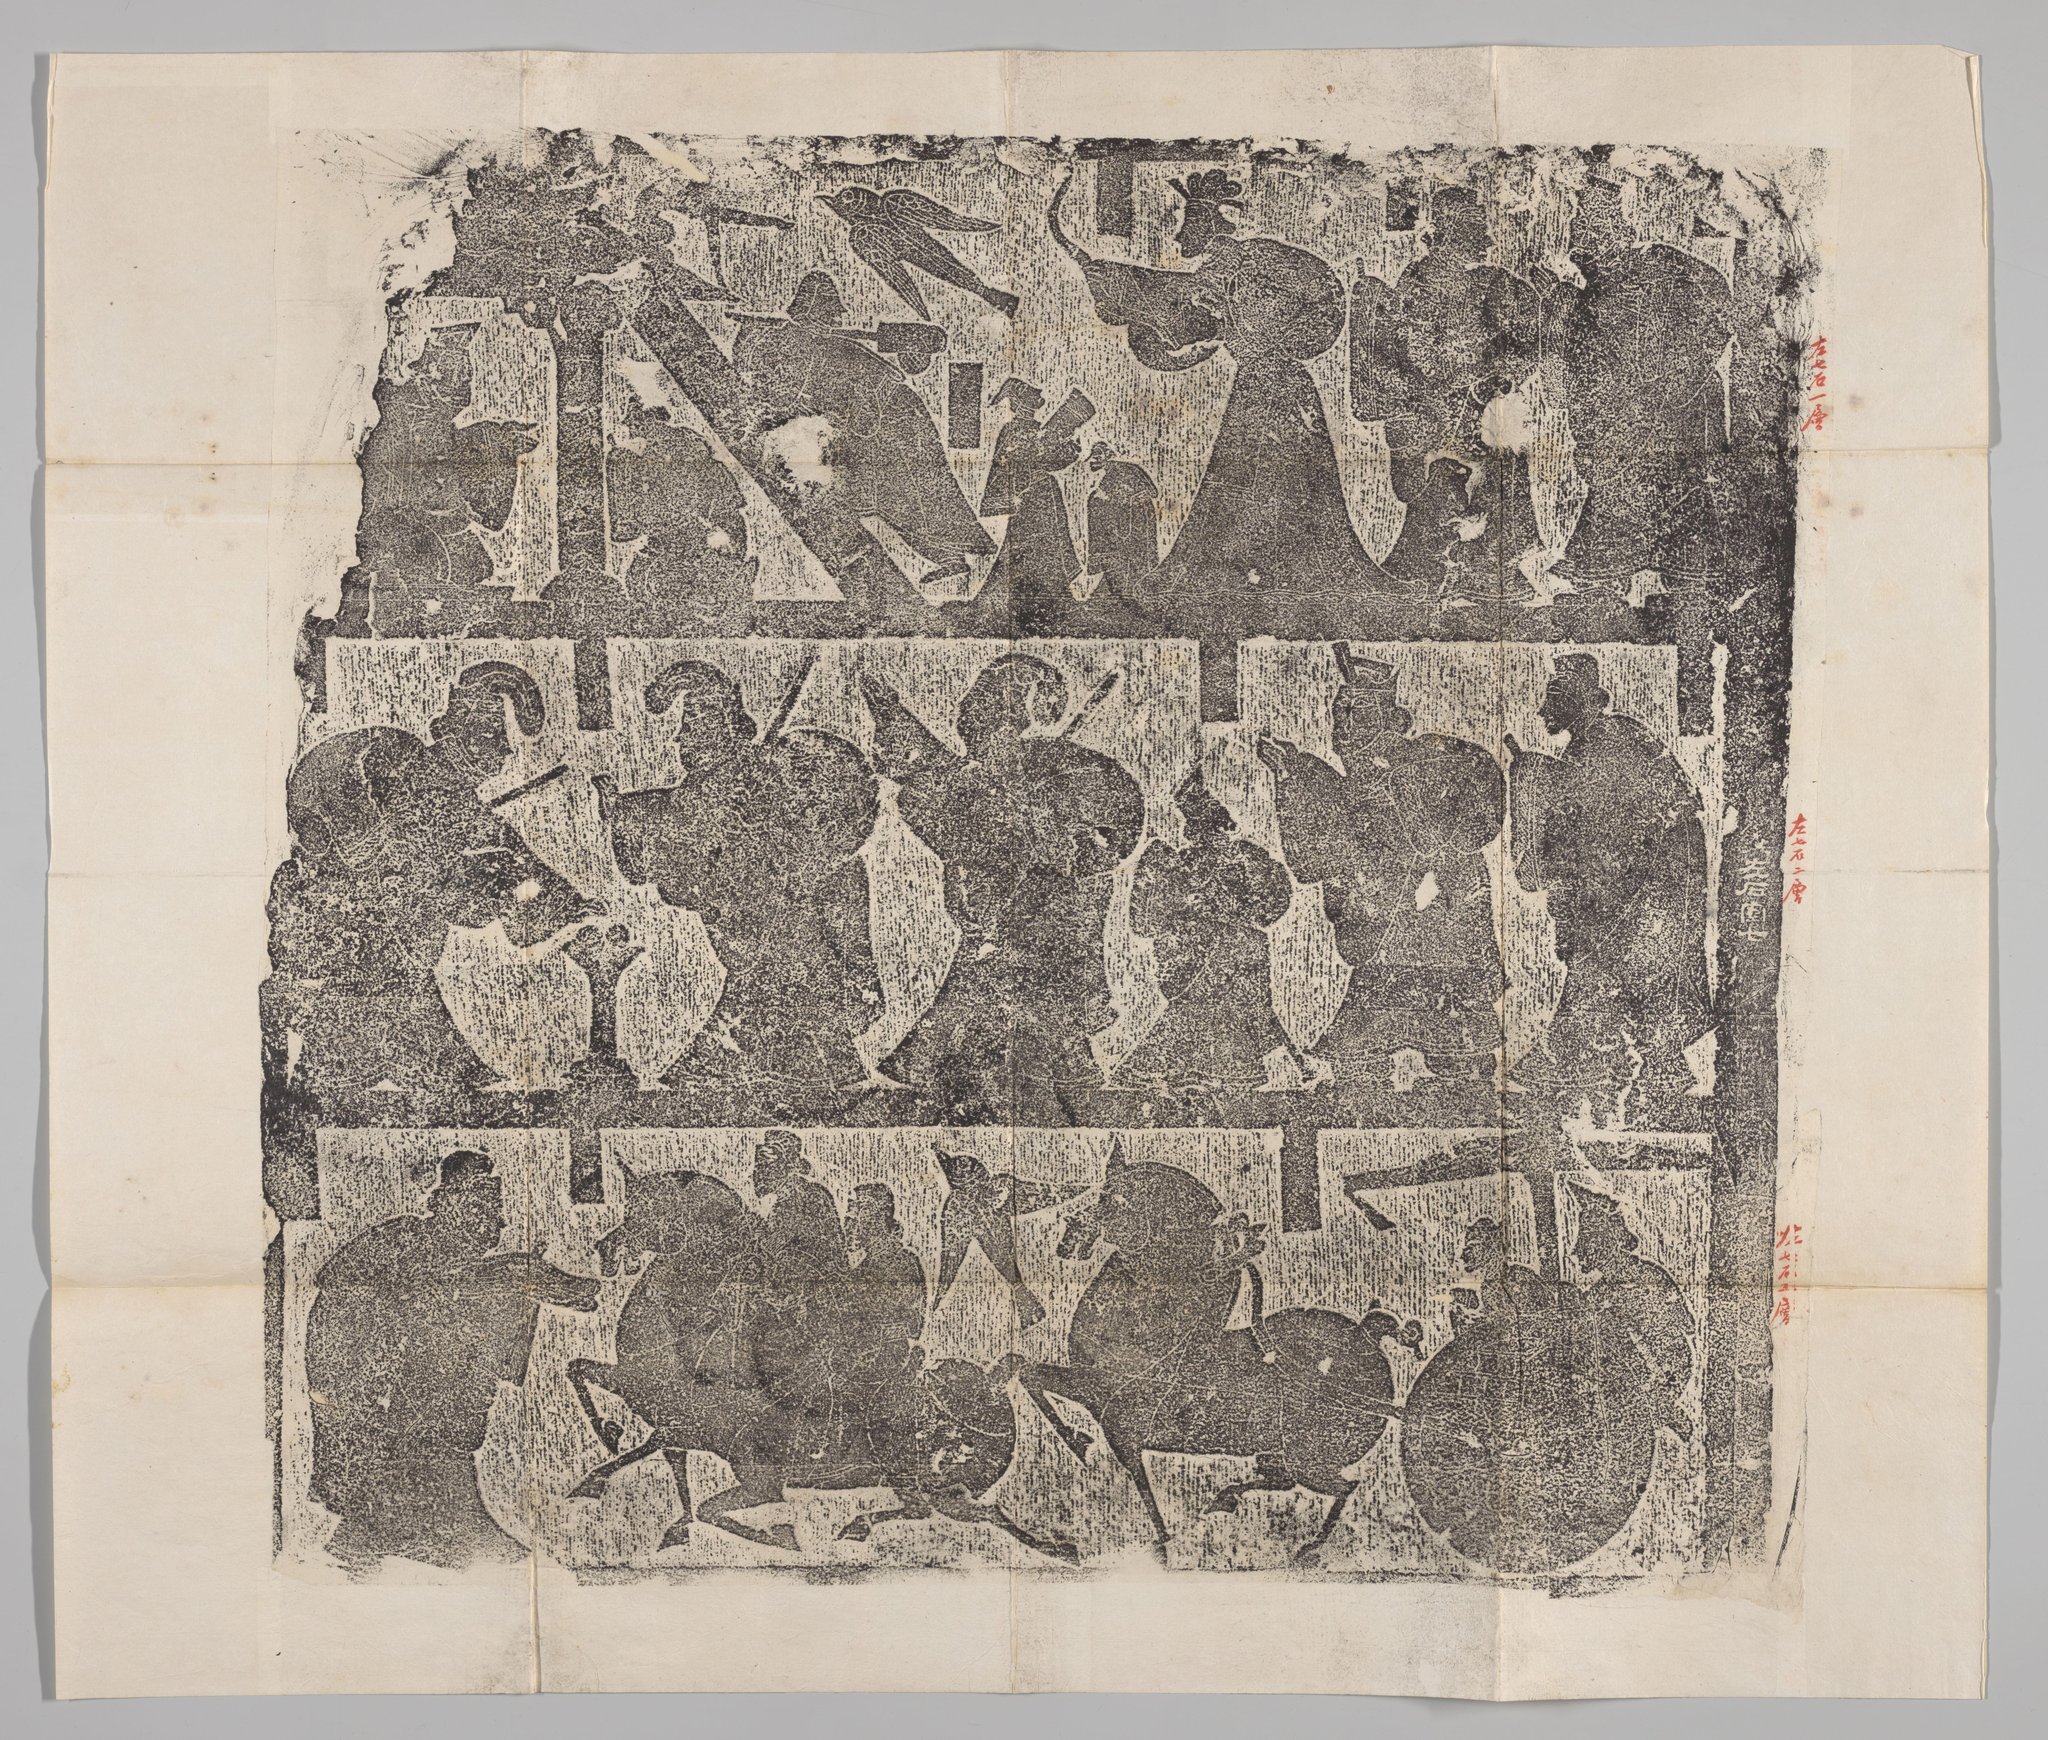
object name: wrijfprent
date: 1900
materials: ink, paper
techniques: rubbing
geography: china